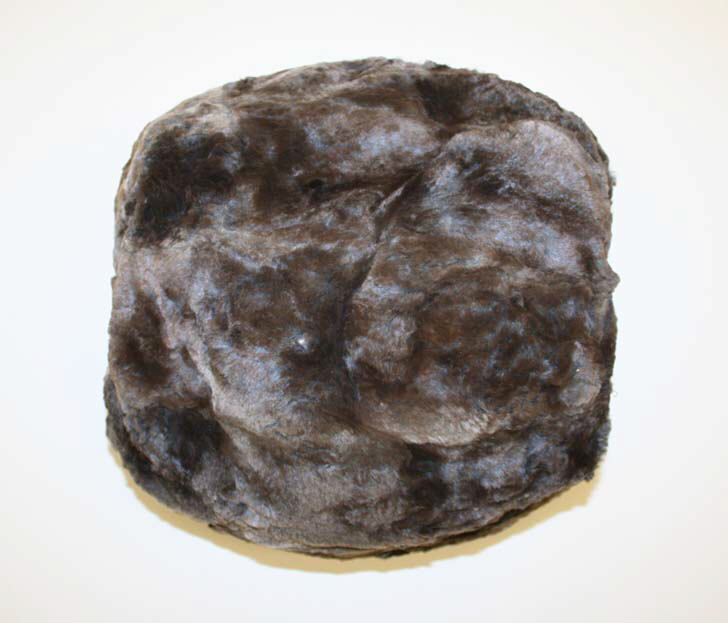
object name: muff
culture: american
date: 1900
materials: fur